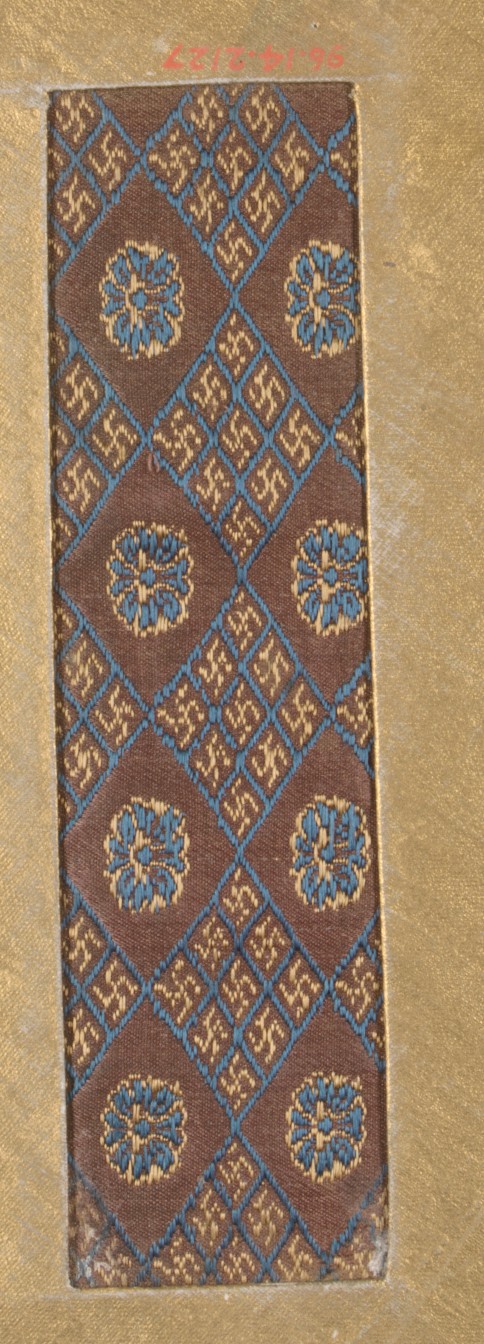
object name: piece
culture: japanese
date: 1701-1900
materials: silk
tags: flowers